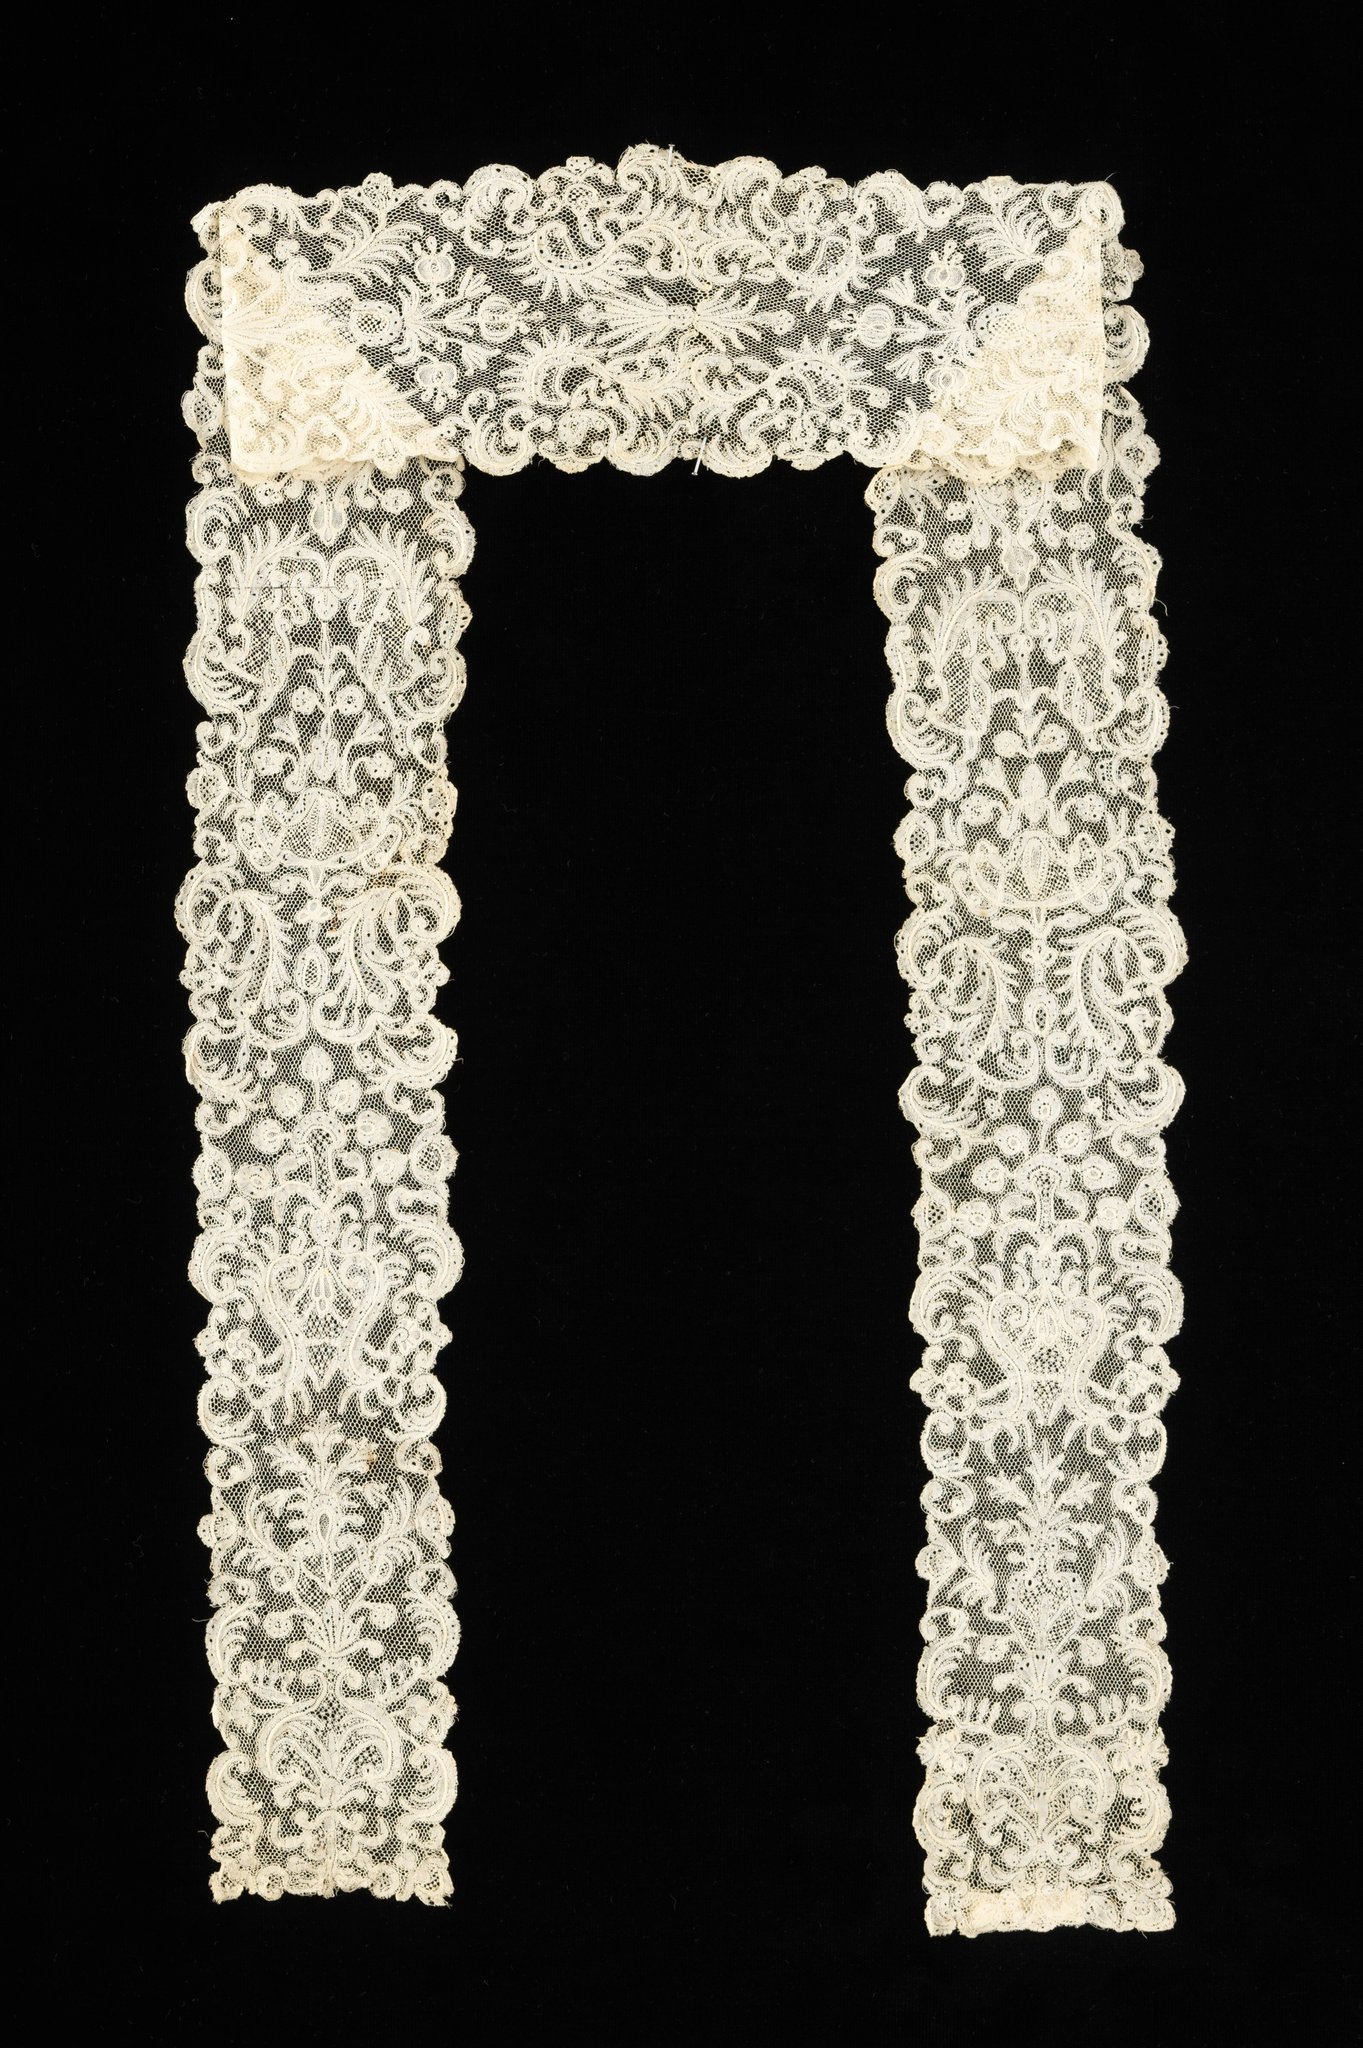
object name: lappet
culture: flemish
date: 1701-1725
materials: linen